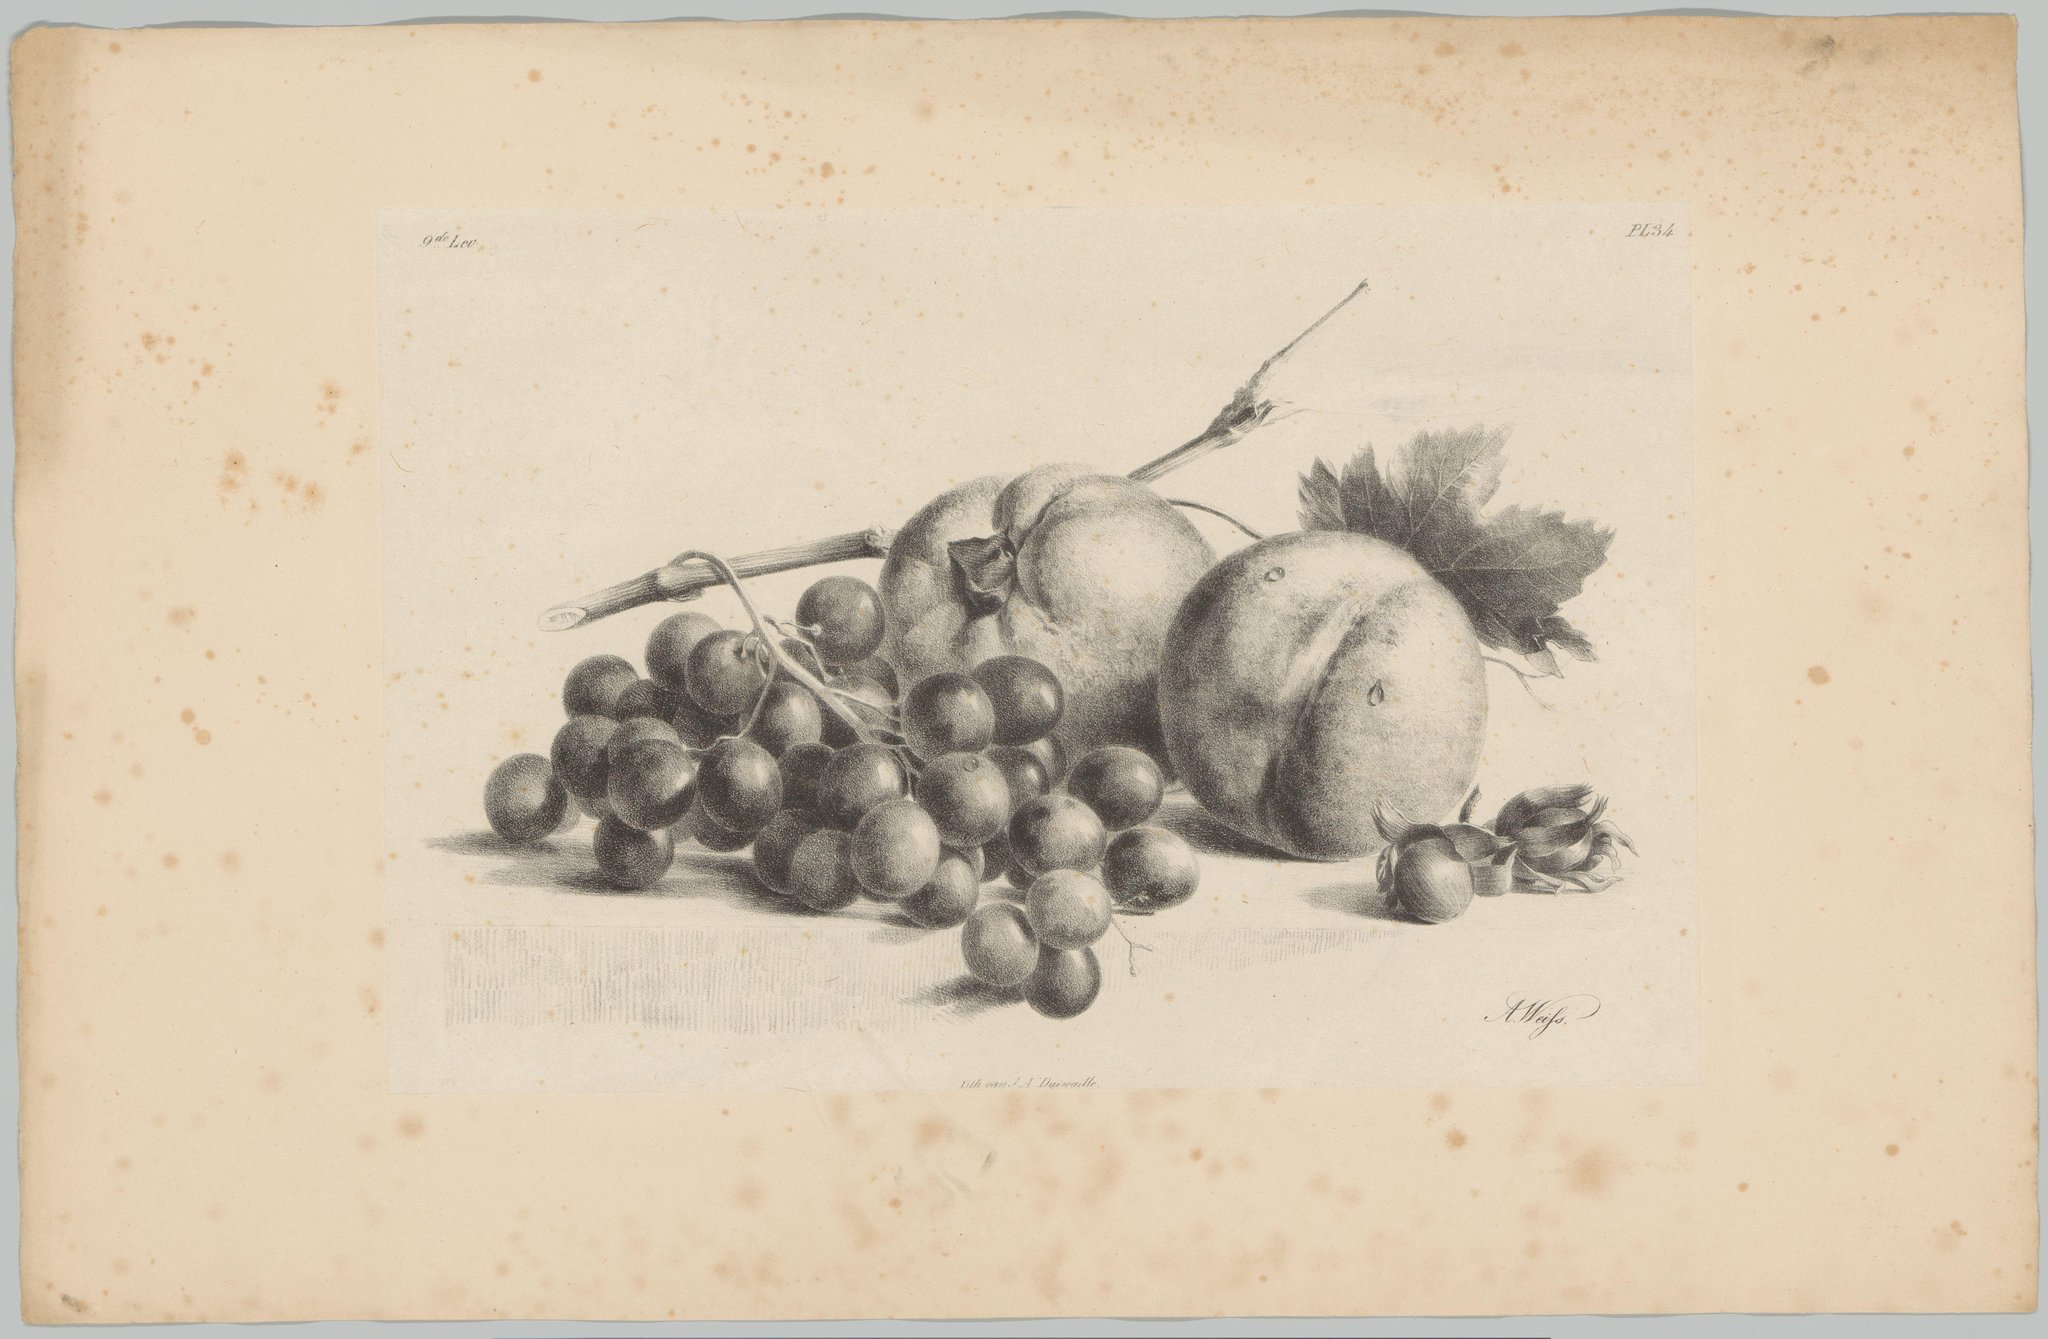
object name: print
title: Bloem en Fruit Studien (...) 3de aflevering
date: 1820-1833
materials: paper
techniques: lithograph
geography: amsterdam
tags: fruits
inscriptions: collector's mark: Lugt 2228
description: Links boven genummerd 9de Lev. Onderdeel van een omslag met in totaal zevenenzeventig lithografieën van bloemen en fruit.